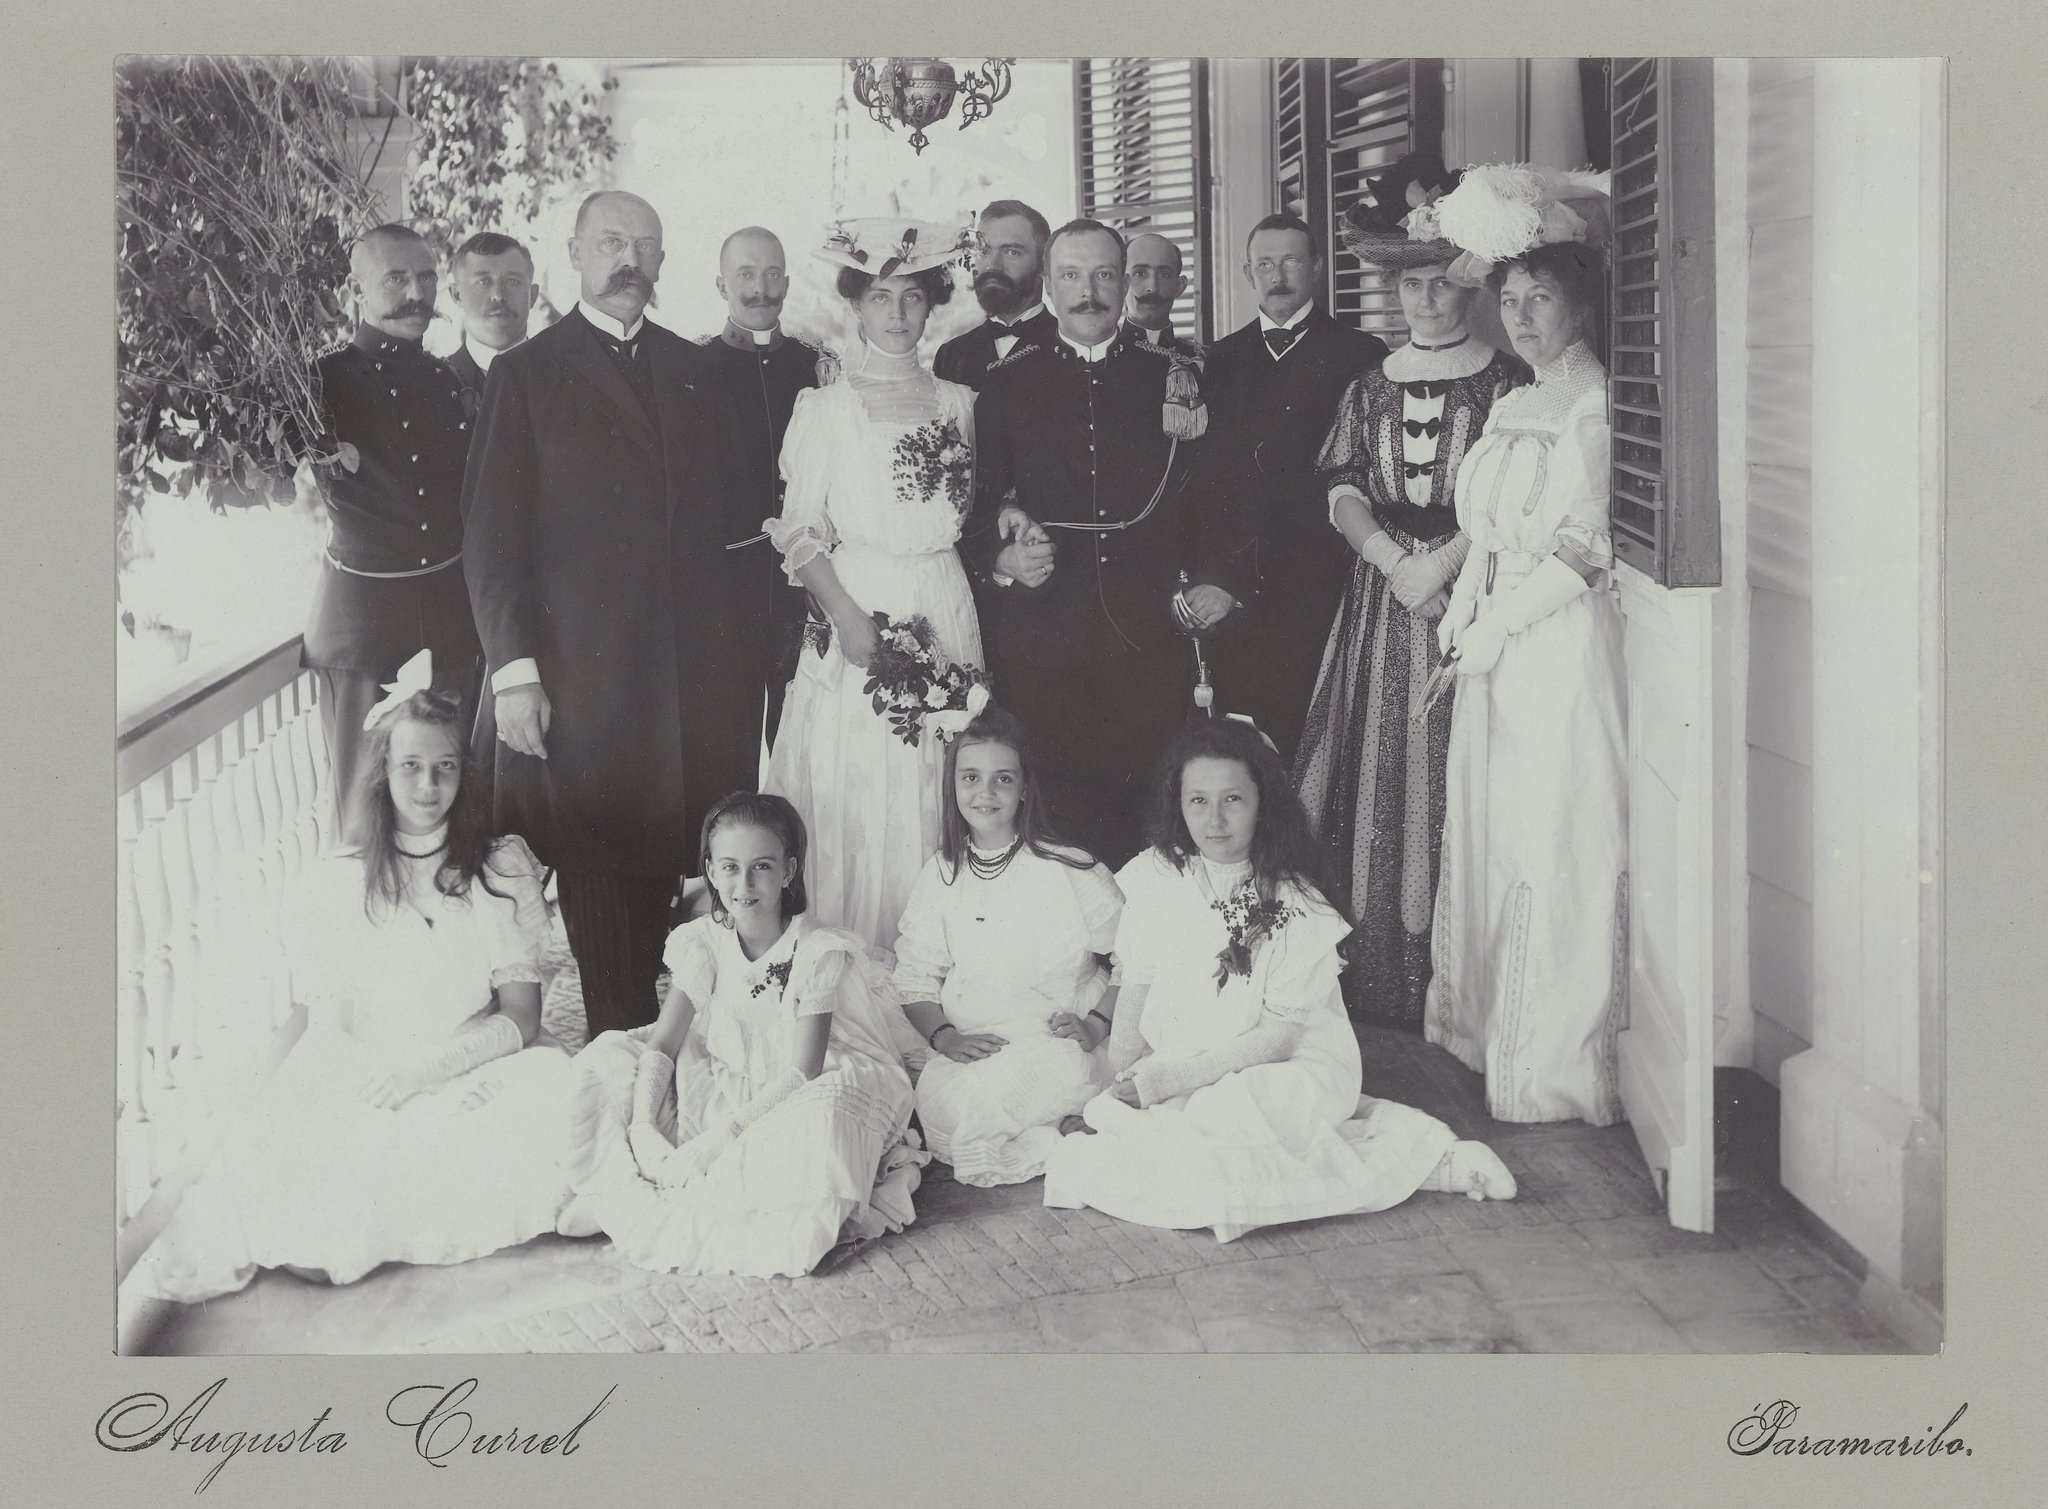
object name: photograph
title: Bruiloft te Paramaribo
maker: augusta curiel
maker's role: fotograaf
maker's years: 1873-1937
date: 1903-1908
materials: photographic support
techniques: photography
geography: paramaribo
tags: (civil) marriage ceremonies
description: Op een waranda staat een groep feestelijk gekleede dames en heren, in het midden een bruid en bruidegom. Naast de bruid staat de heer P. Hofstede Crull. Voor de groep zitten vier bruidsmeisjes op de grond. Te Paramaribo, Suriname.